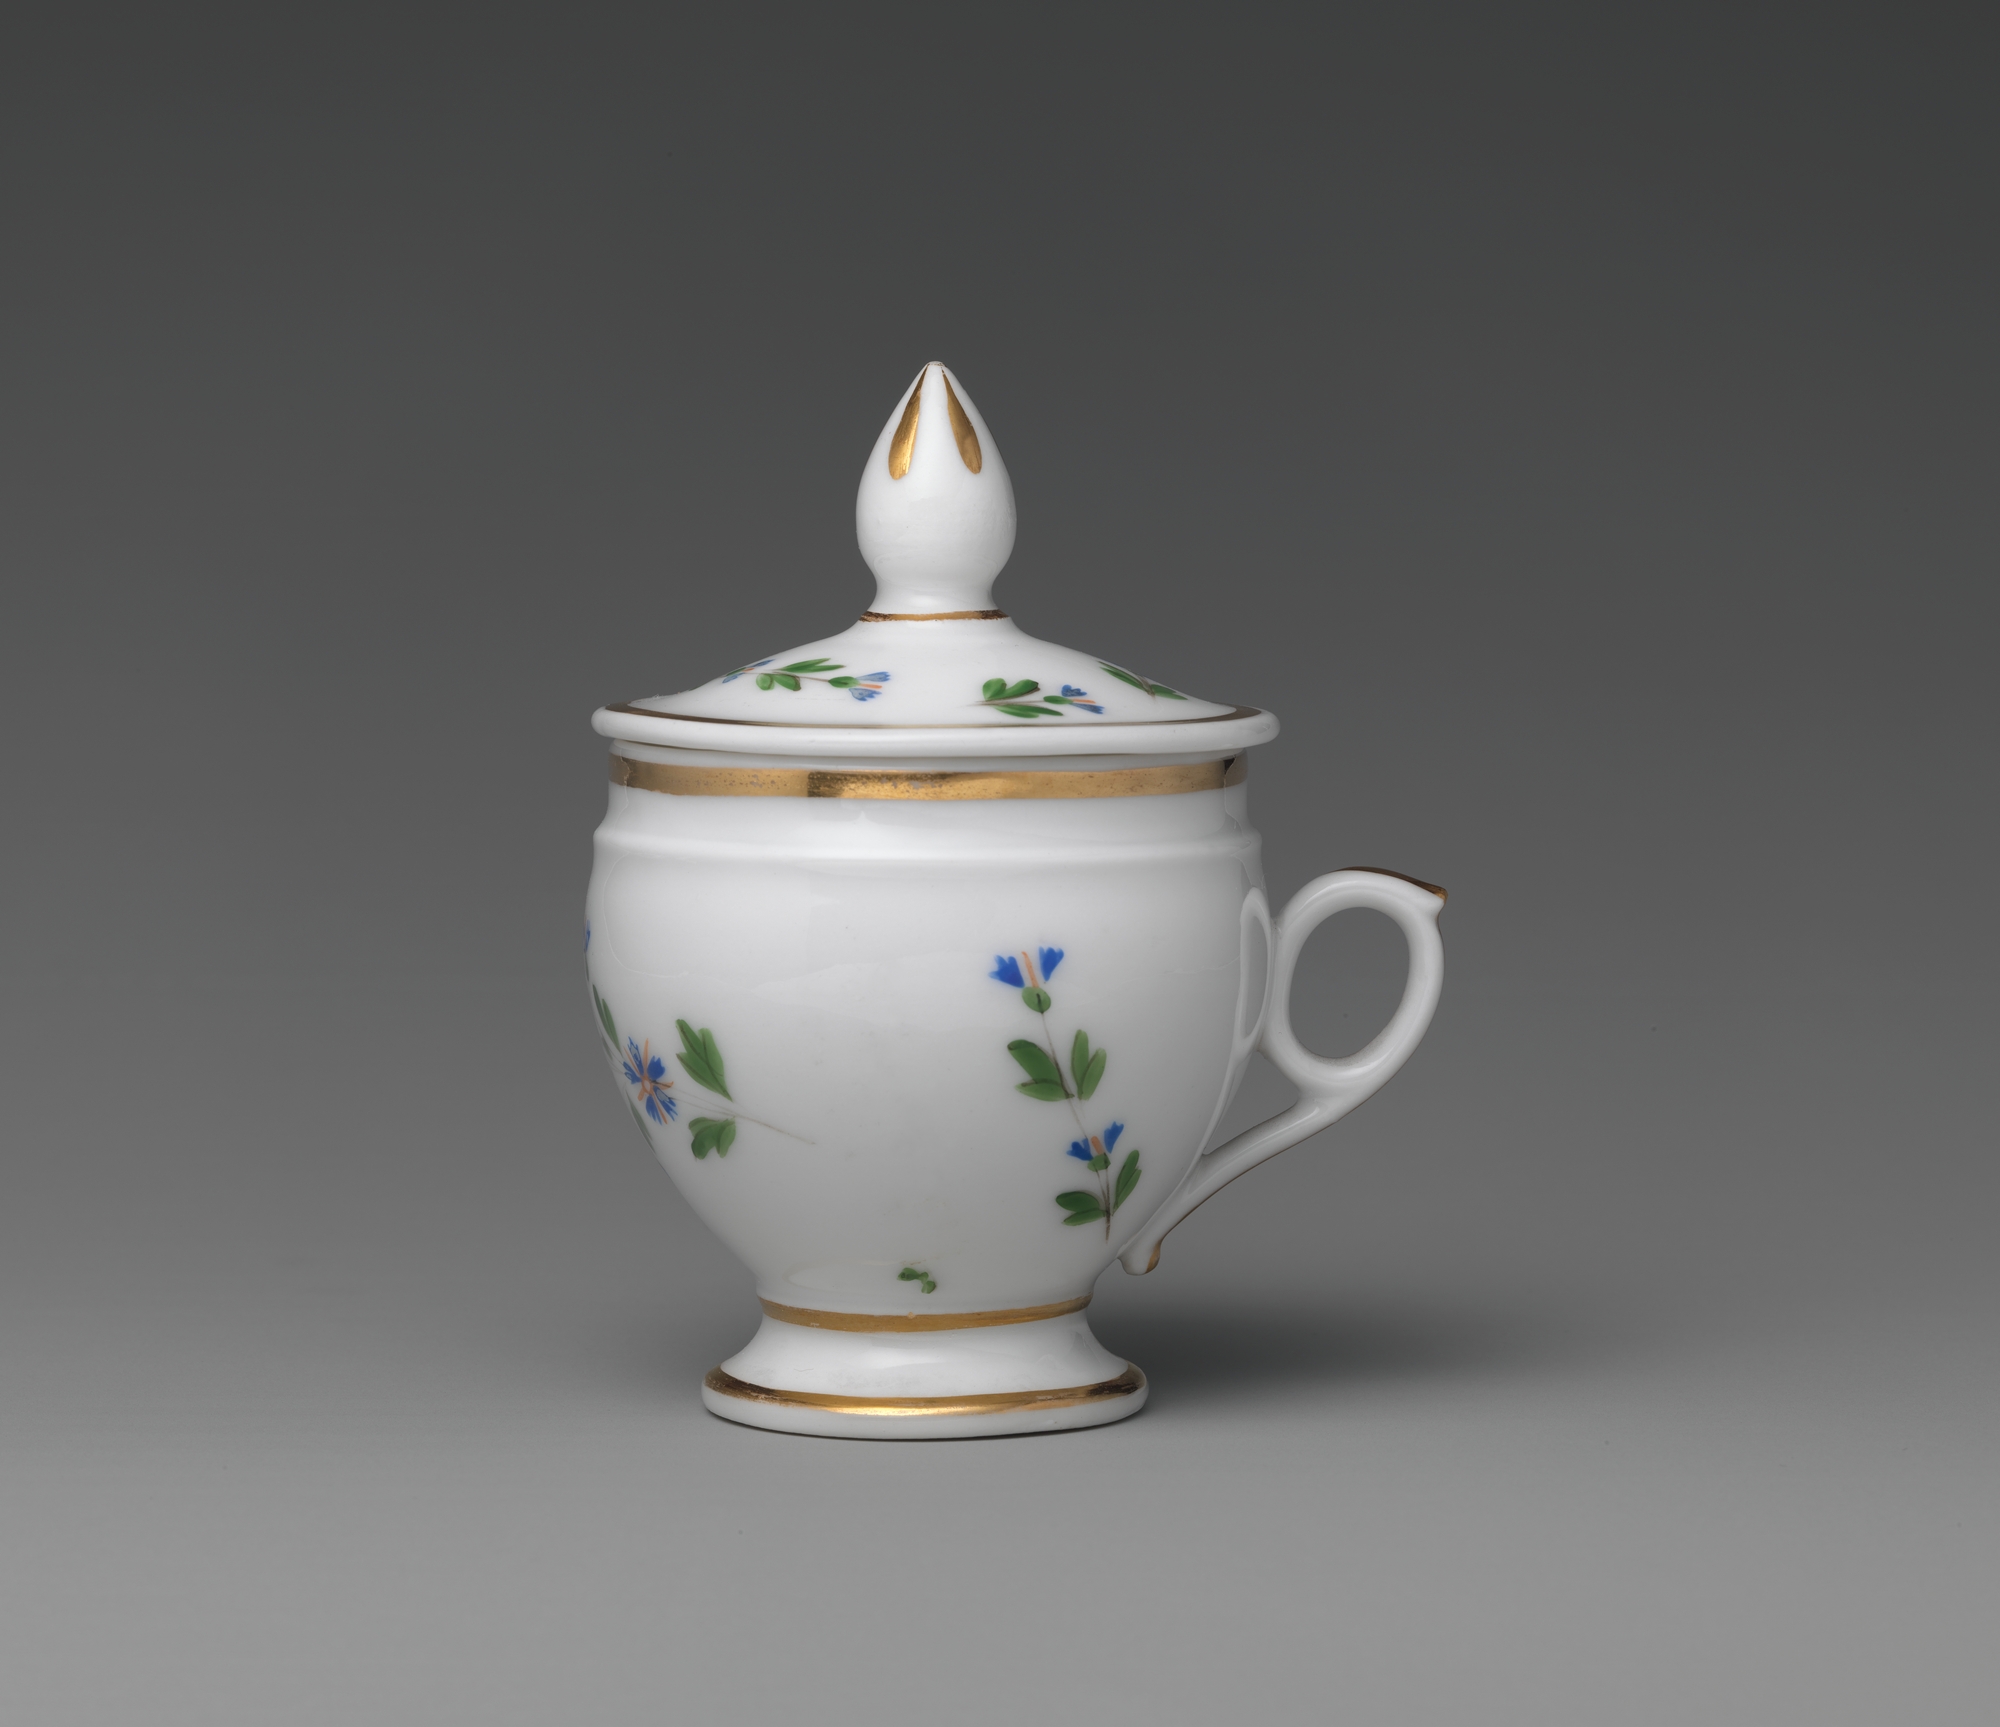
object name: custard cup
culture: french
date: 1815-1830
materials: porcelain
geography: france